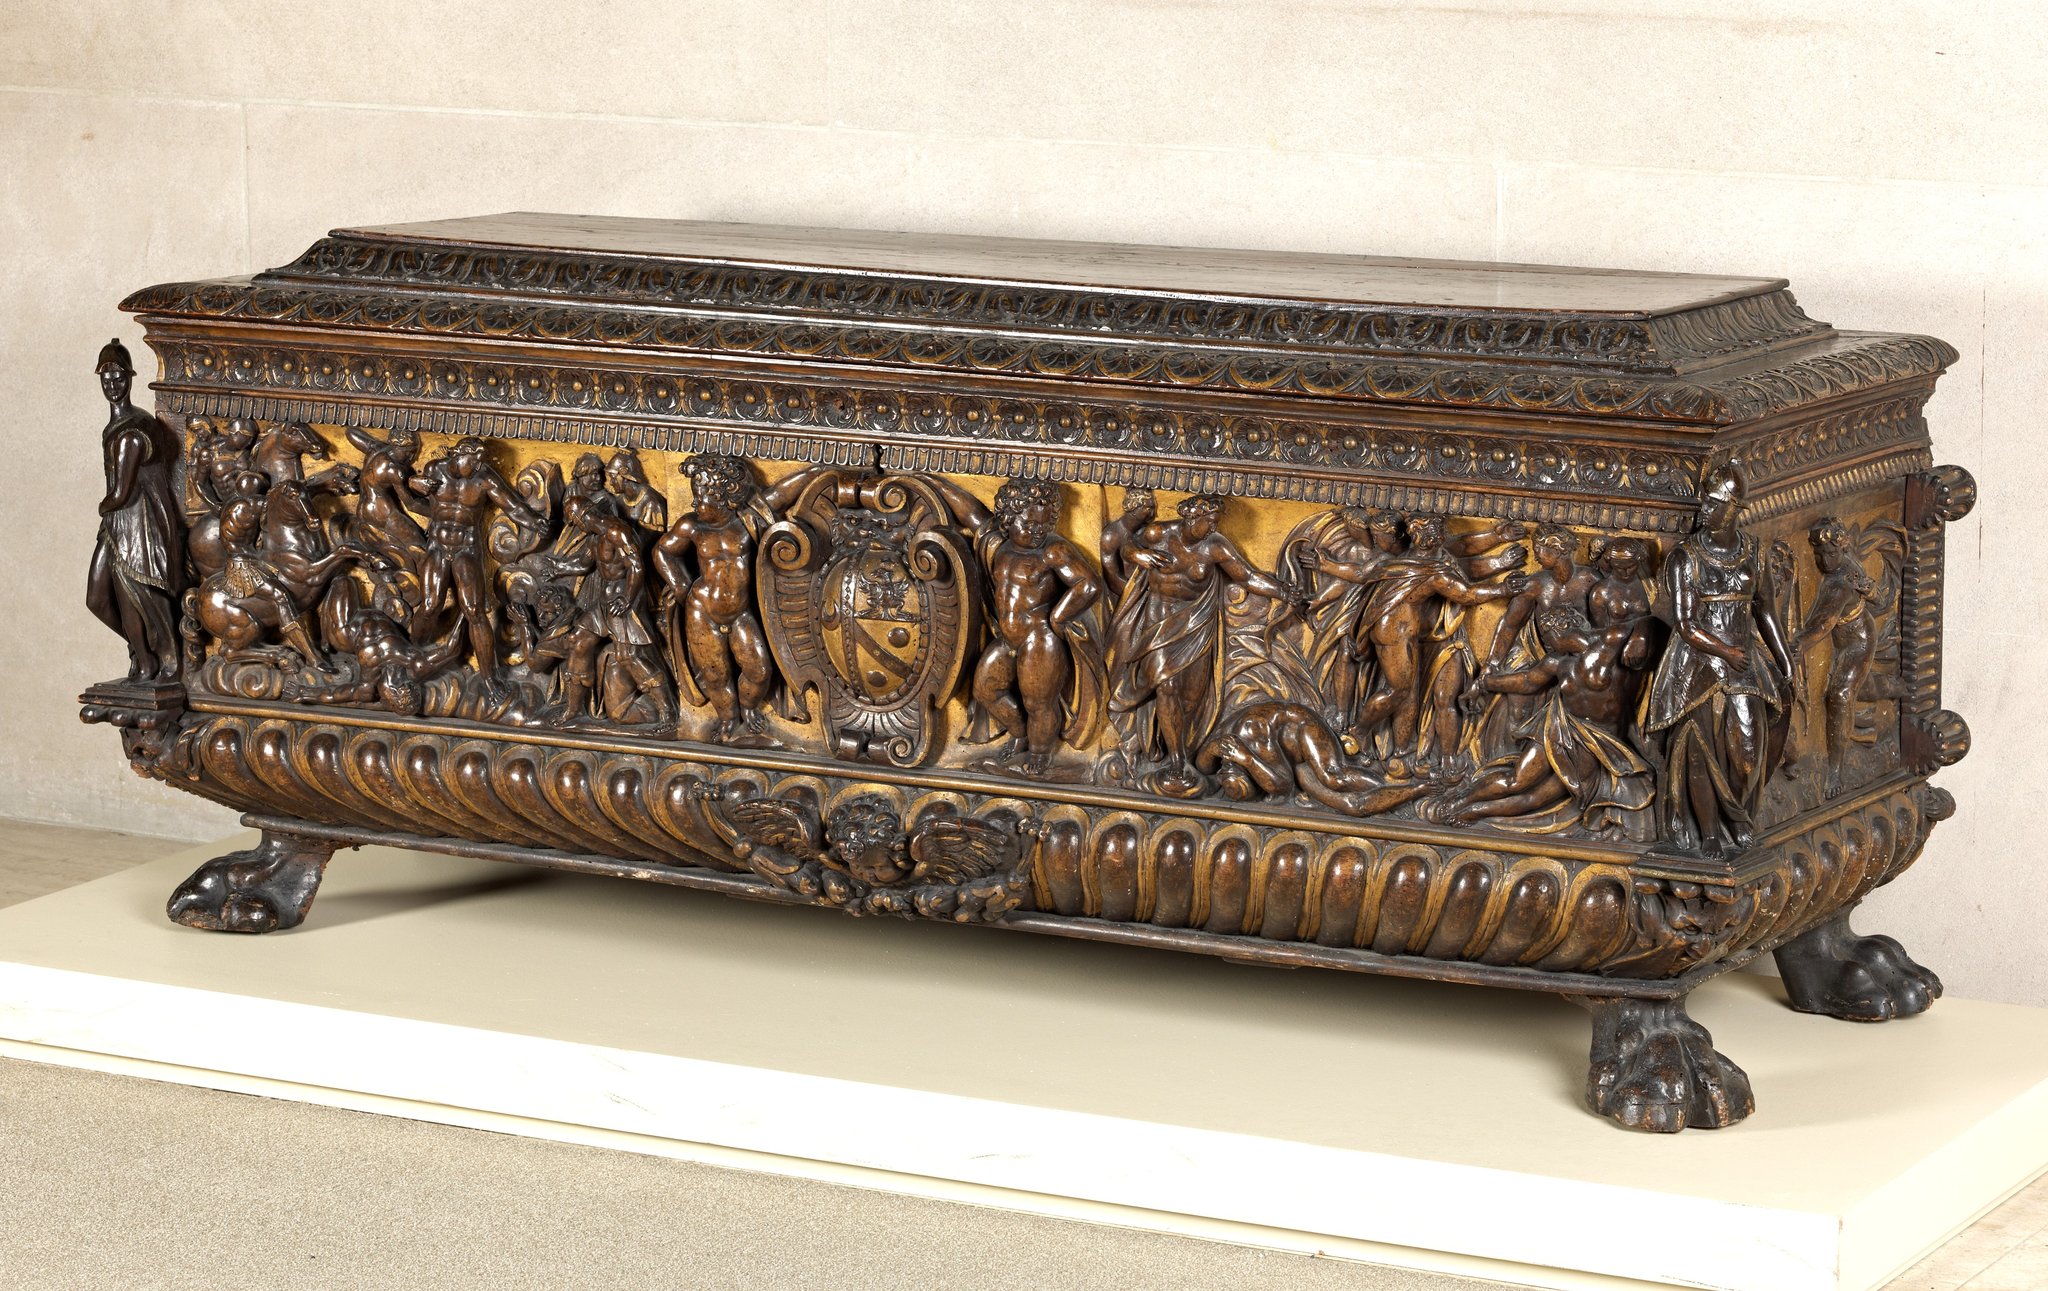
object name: chest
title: Cassone (chest), pair with 1975.1.1940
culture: italian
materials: wood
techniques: carving, gilding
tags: men,male nudes,horses,coat of arms